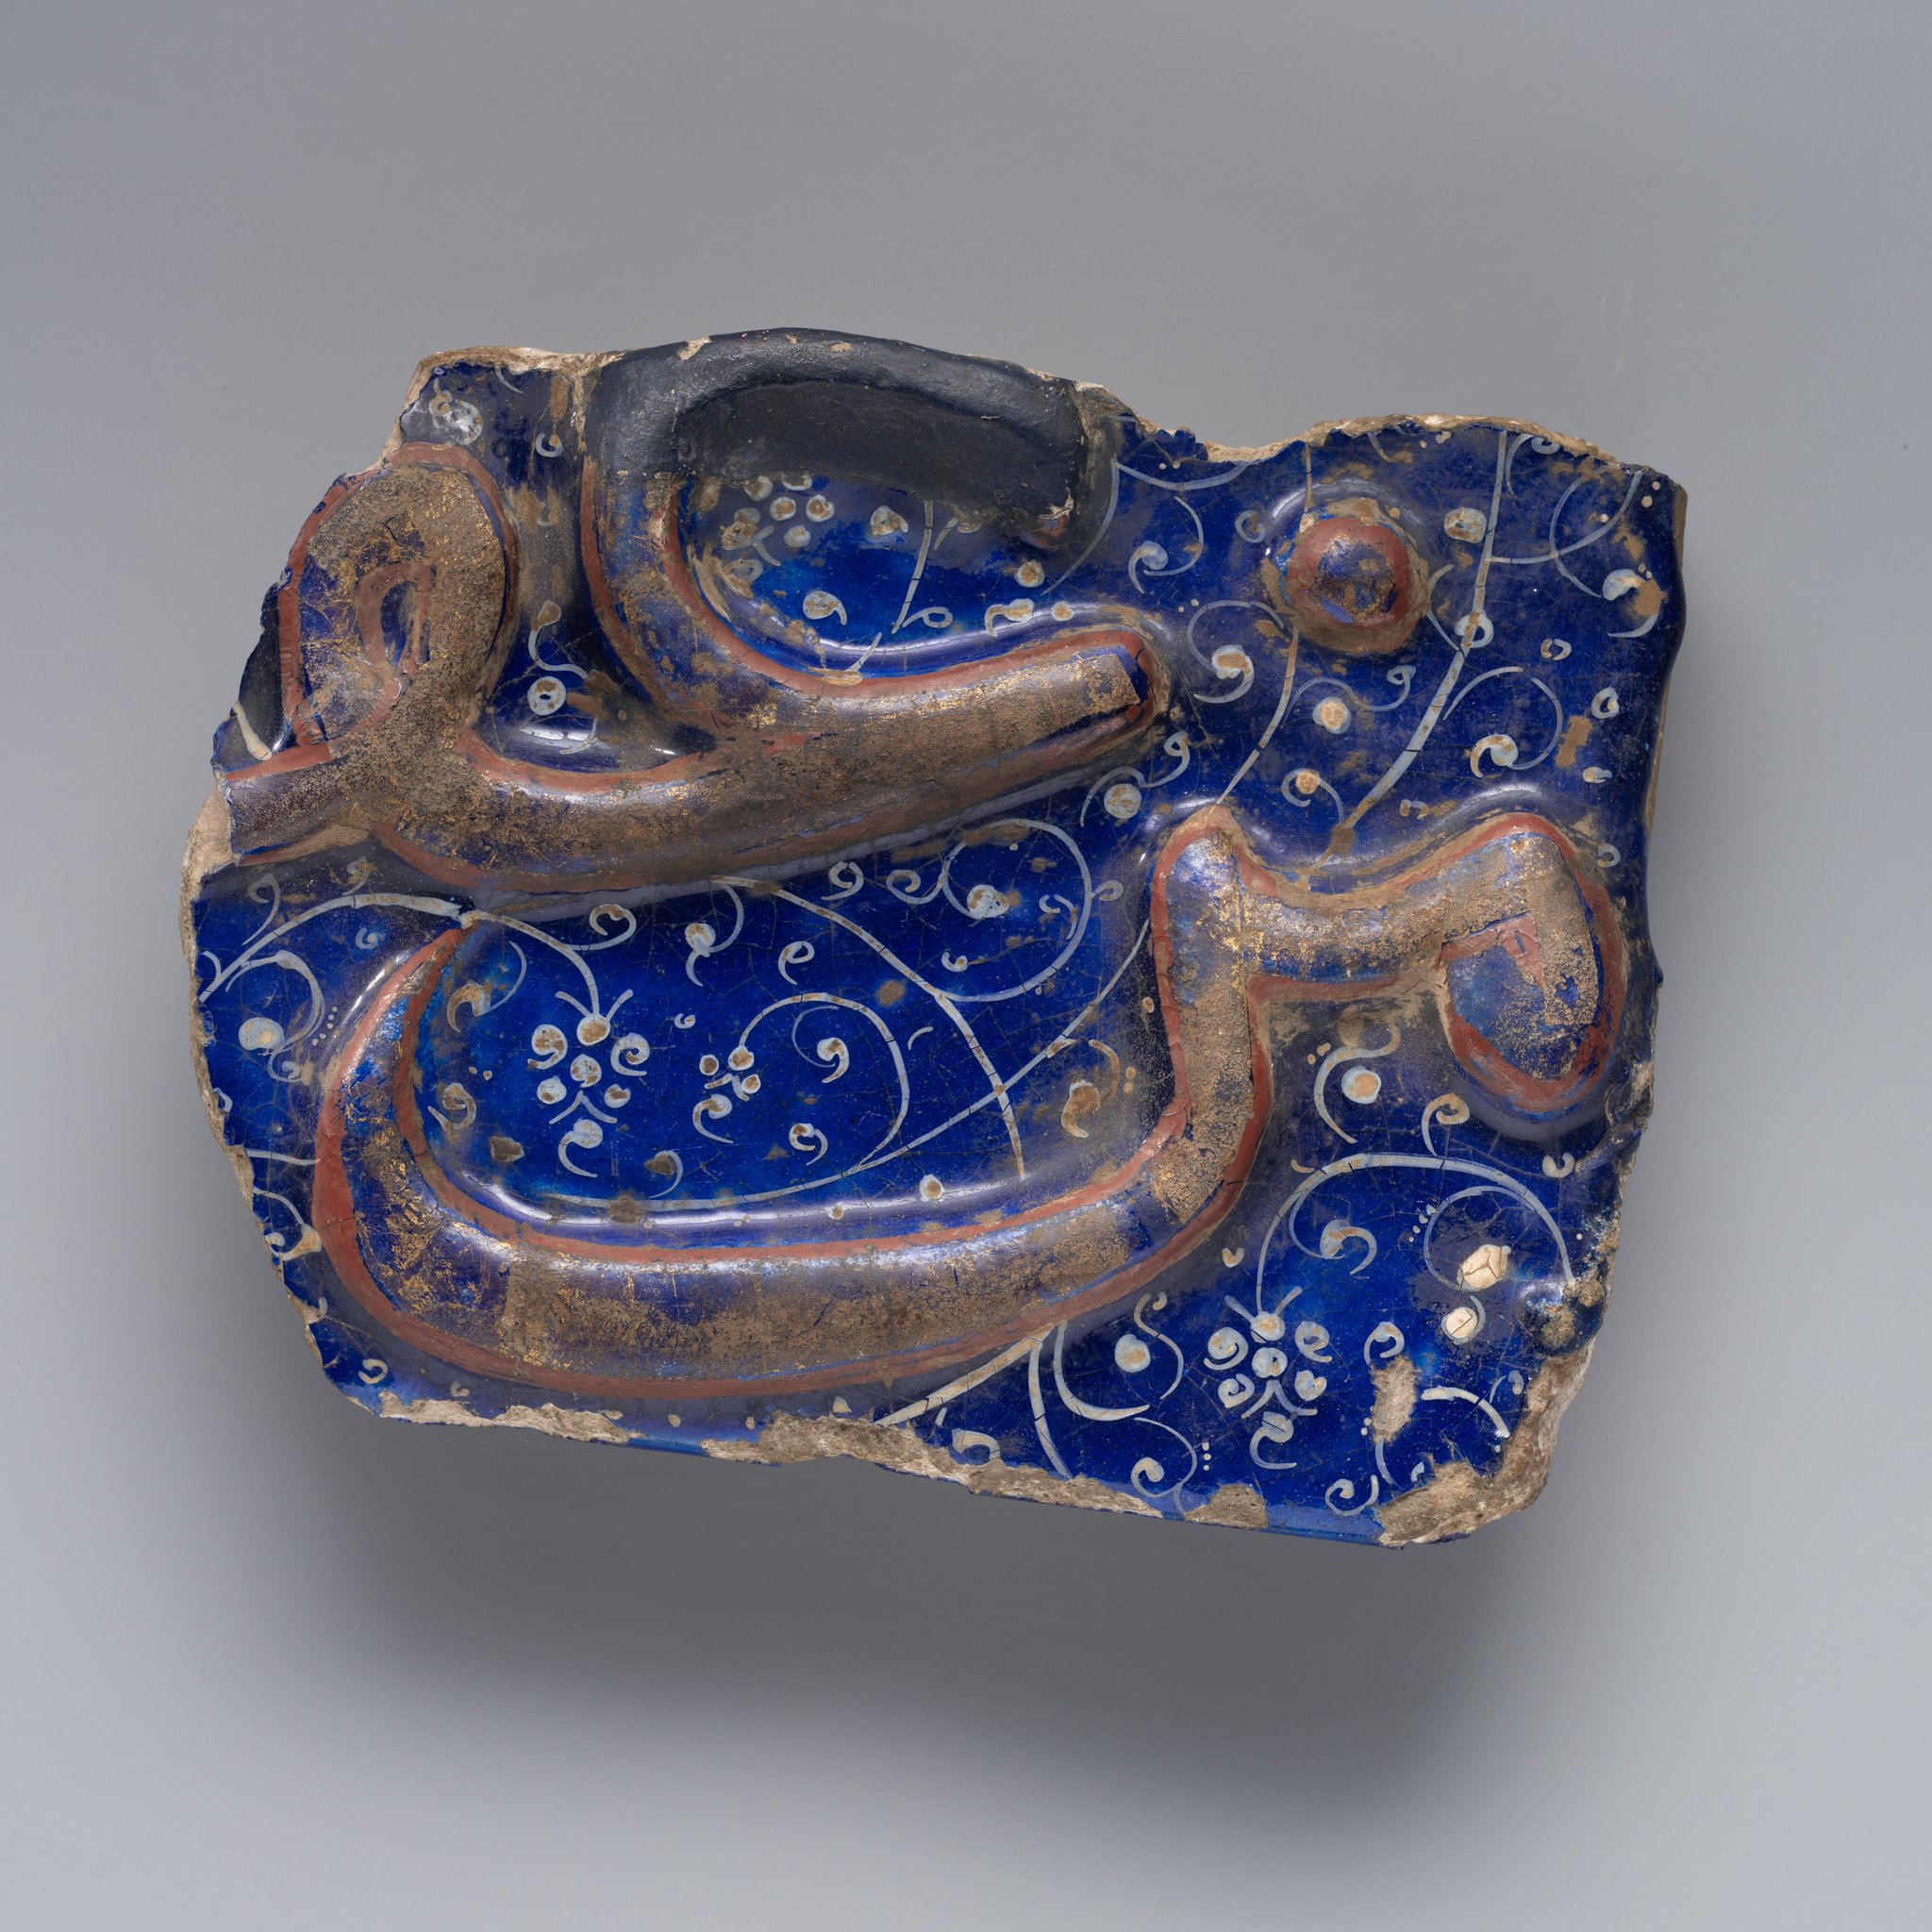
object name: tile fragment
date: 1334-1366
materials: stonepaste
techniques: gilding, molding, overglaze, painting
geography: iran